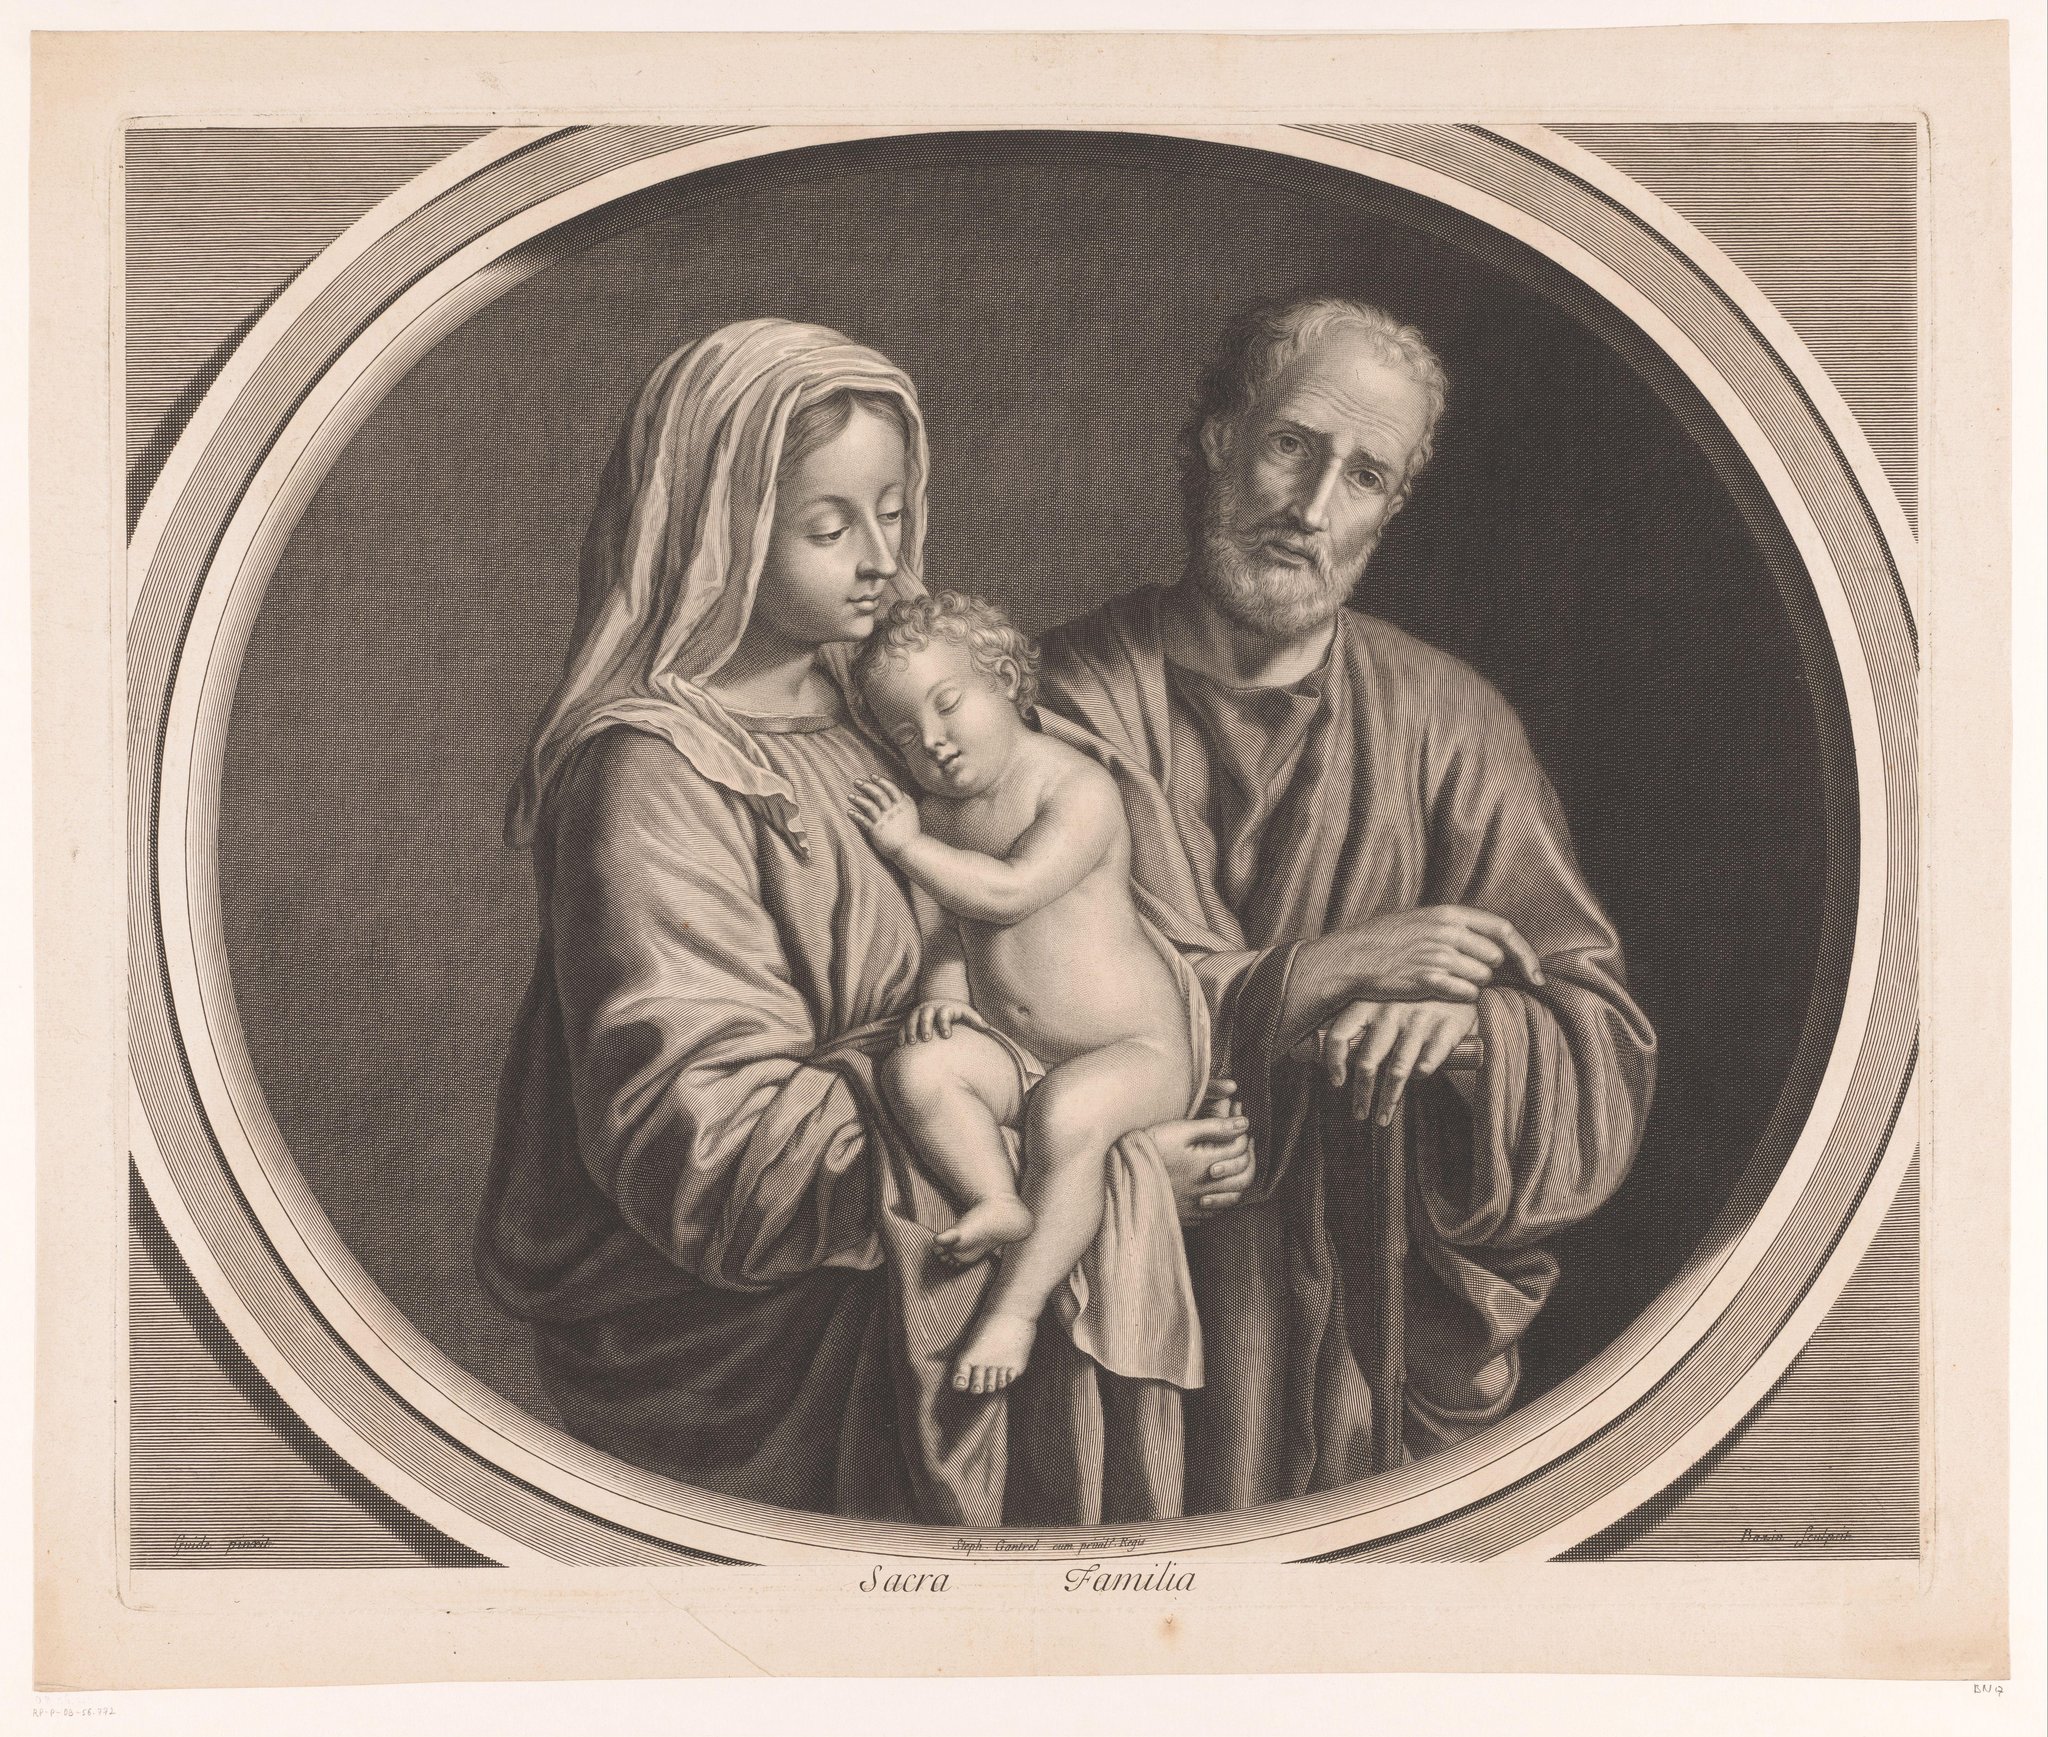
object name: print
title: Heilige Familie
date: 1643-1710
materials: paper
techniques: engraving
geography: paris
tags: holy family, and derived representations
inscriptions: collector's mark: Lugt 2228